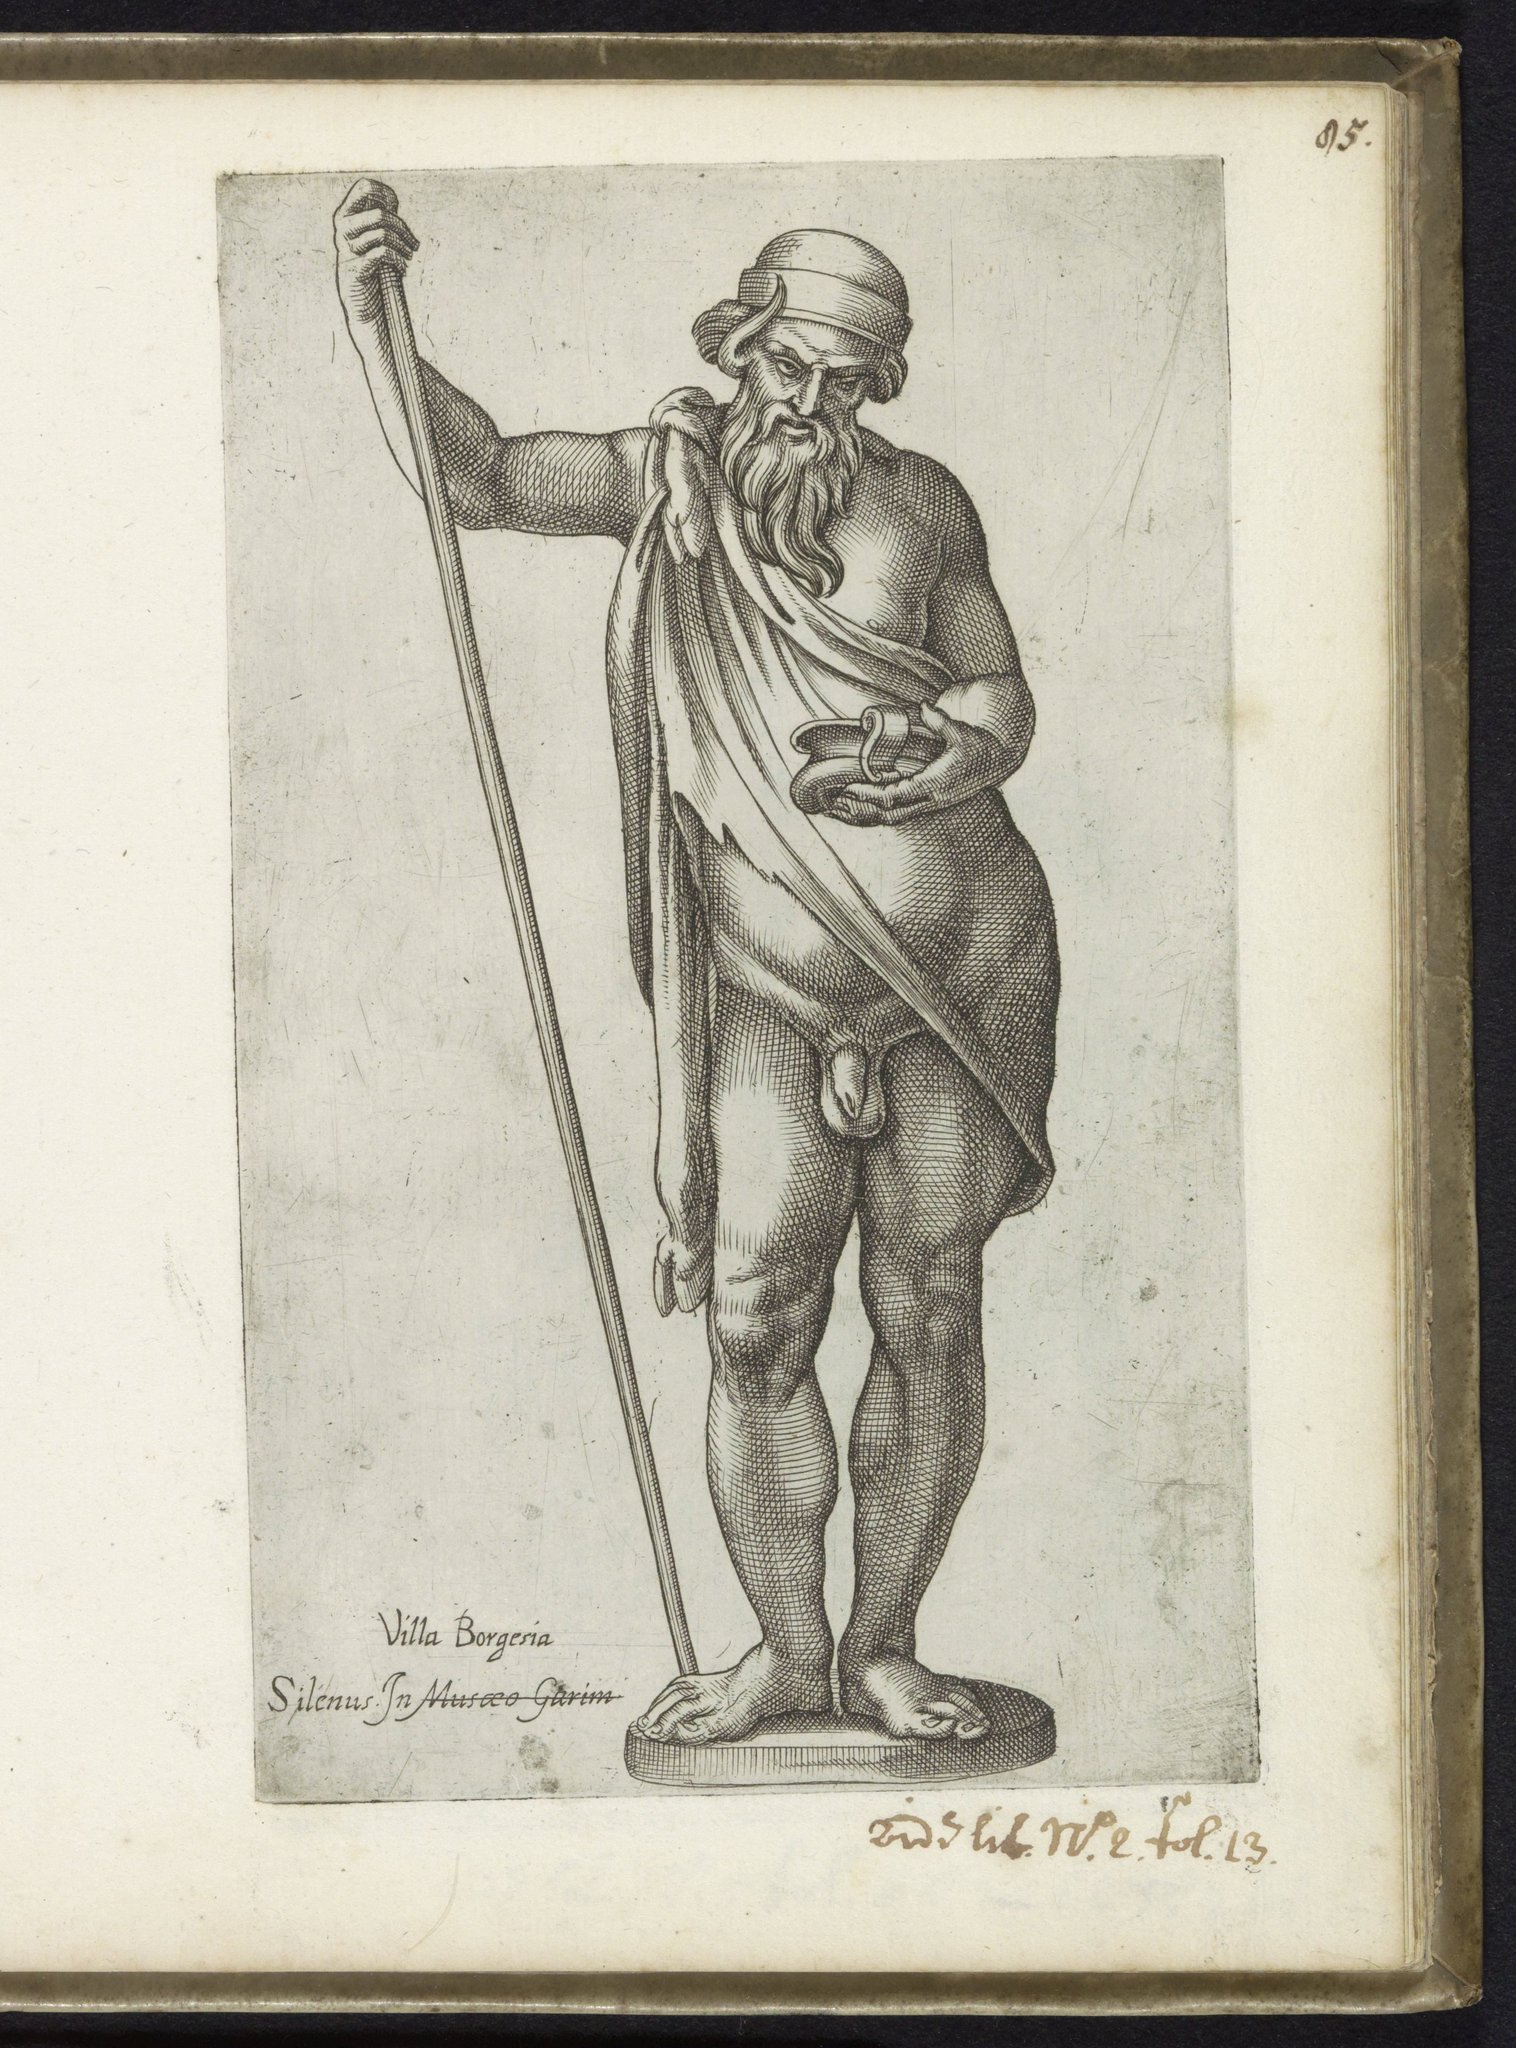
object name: print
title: Sculpturen uit de oudheid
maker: Anonymous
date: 1600-1699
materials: paper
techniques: engraving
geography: italy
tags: (story of) silenus, piece of sculpture, reproduction of a piece of sculpture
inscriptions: inscription: ‘Ende lib. no. 2. fol. 13.’, number: ‘85’, inscription: ‘Ende [...] lib. No. 27./ Ende lib. No. 21. fol. 2./ Ende lib. No. 23. fol. 143.’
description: Deze prent maakt deel uit van een reeks van ten minste 50 prenten van sculpturen uit de oudheid.